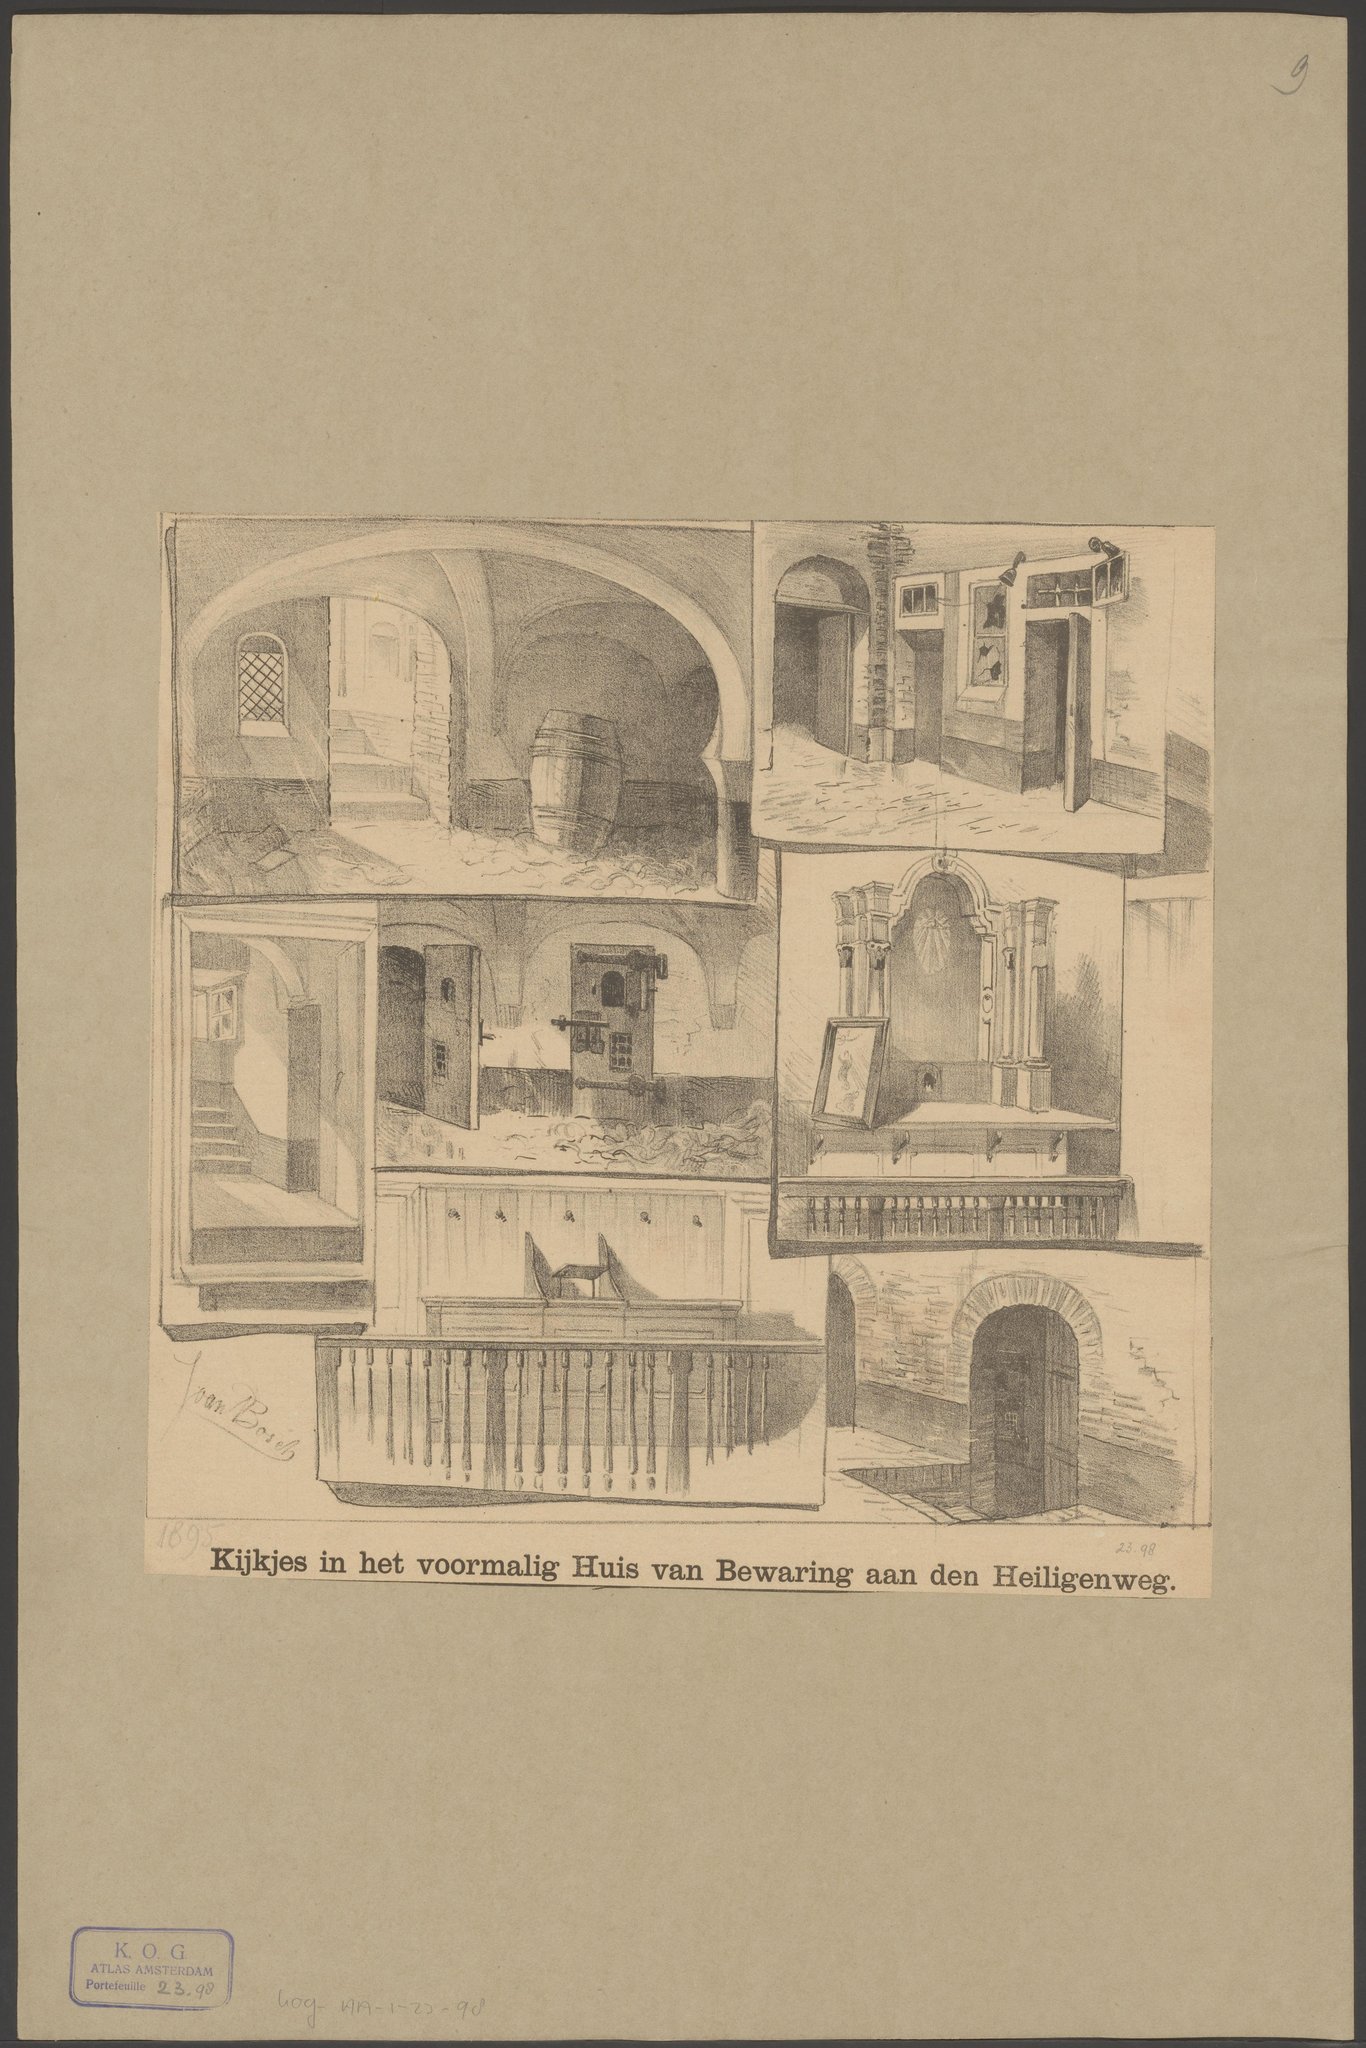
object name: print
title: Verschillende impressies van het Rasphuis te Amsterdam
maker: joan bosch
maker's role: print maker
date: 1803-1895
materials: paper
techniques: letterpress printing, lithograph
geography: netherlands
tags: prison, jail, open door, fixed altar, workhouse, penal camp, penitentiary, chain gang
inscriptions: collector's mark: Lugt 1641b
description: Prent uit of gepubliceerd als bijvoegsel van een onbekende publicatie.